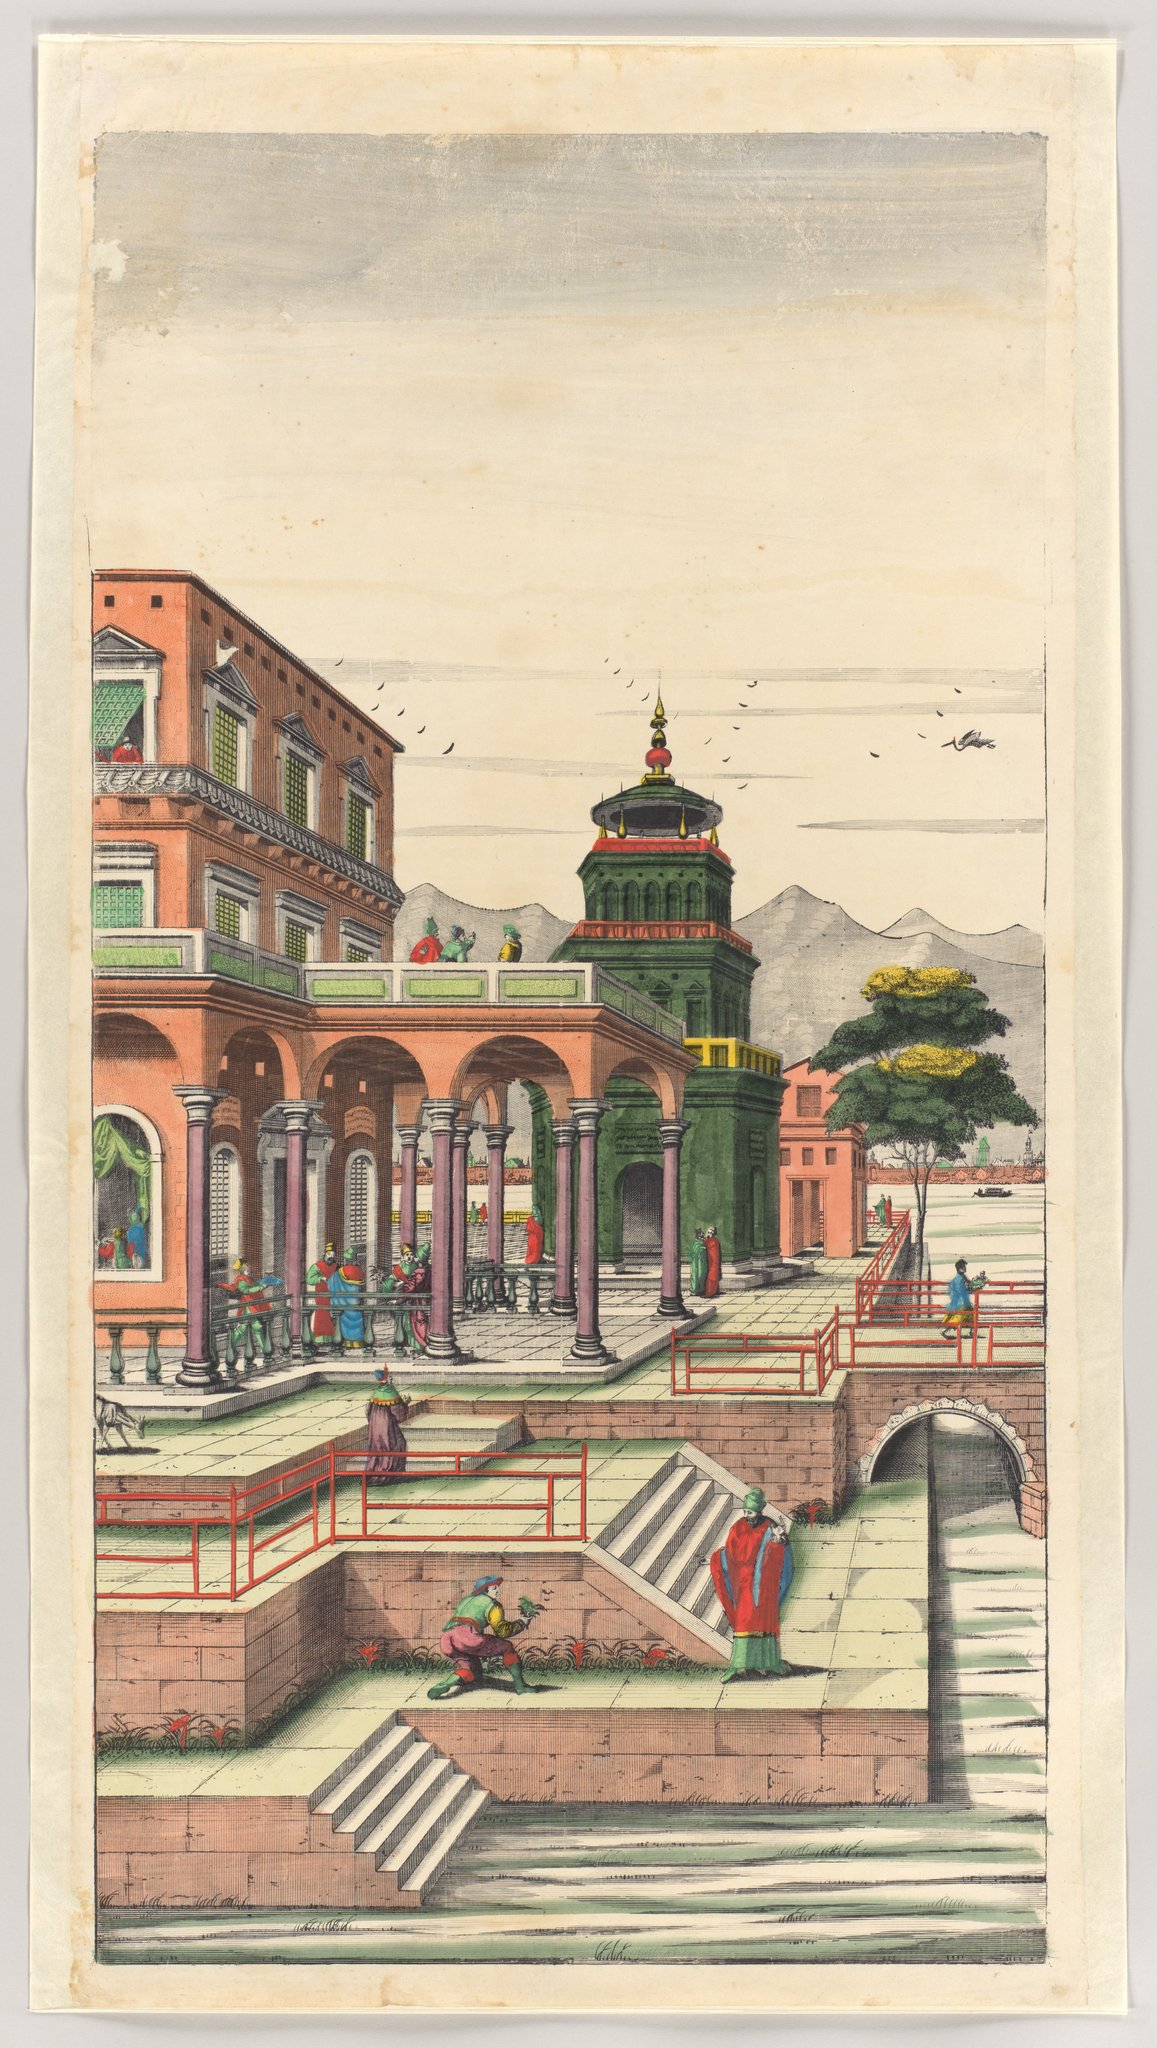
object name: print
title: View of Western architecture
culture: chinese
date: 1701-1800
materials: ink, paper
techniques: hand coloring, woodblock print